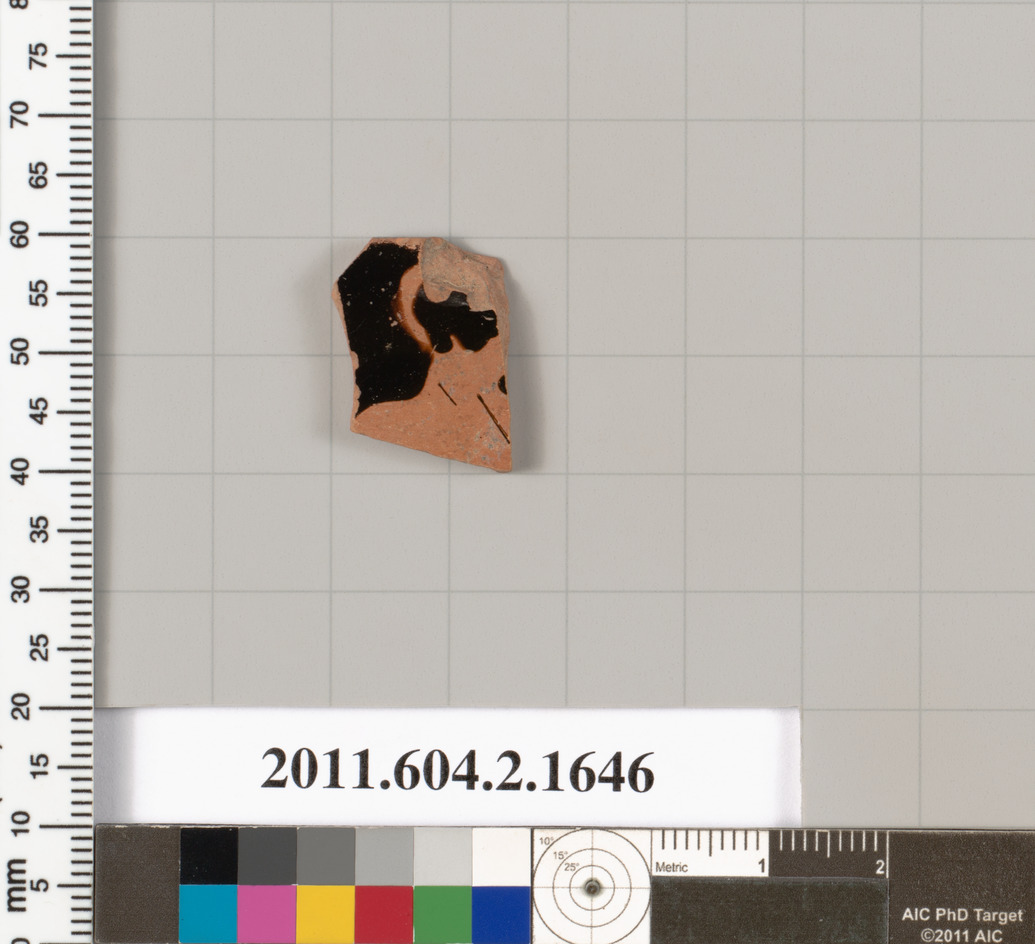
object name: skyphos fragment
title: Terracotta rim fragment of a skyphos (deep drinking cup)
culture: greek, attic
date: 450-426 BCE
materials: terracotta